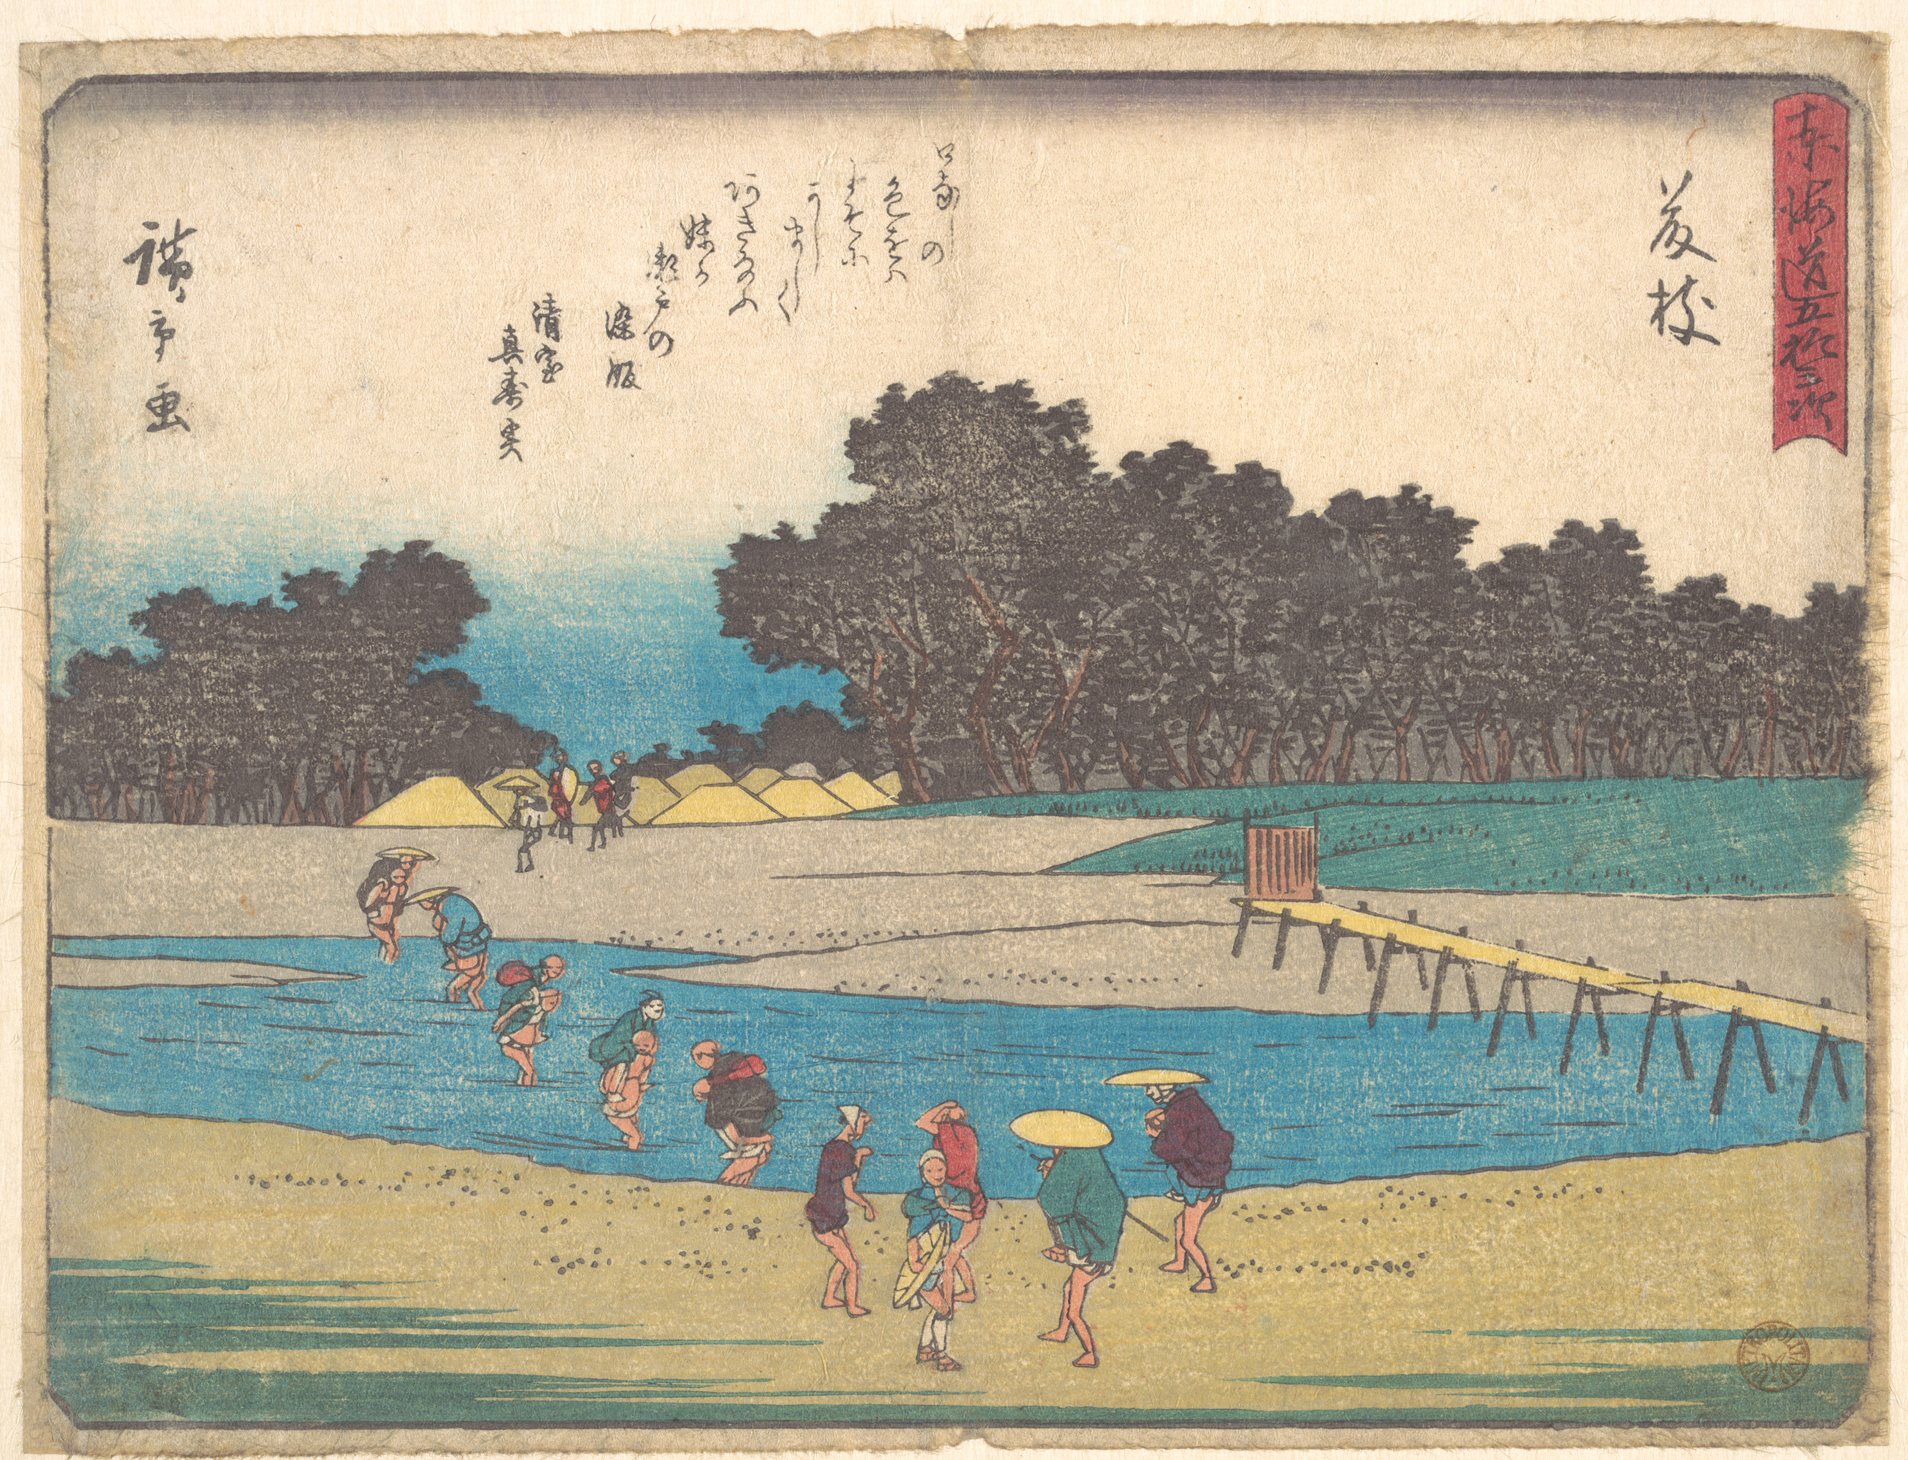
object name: print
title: Fujieda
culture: japanese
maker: utagawa hiroshige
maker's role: artist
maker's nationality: japanese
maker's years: 1797-1858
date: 1838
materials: ink, paper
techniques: woodblock print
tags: human figures,bridges,trees,streams